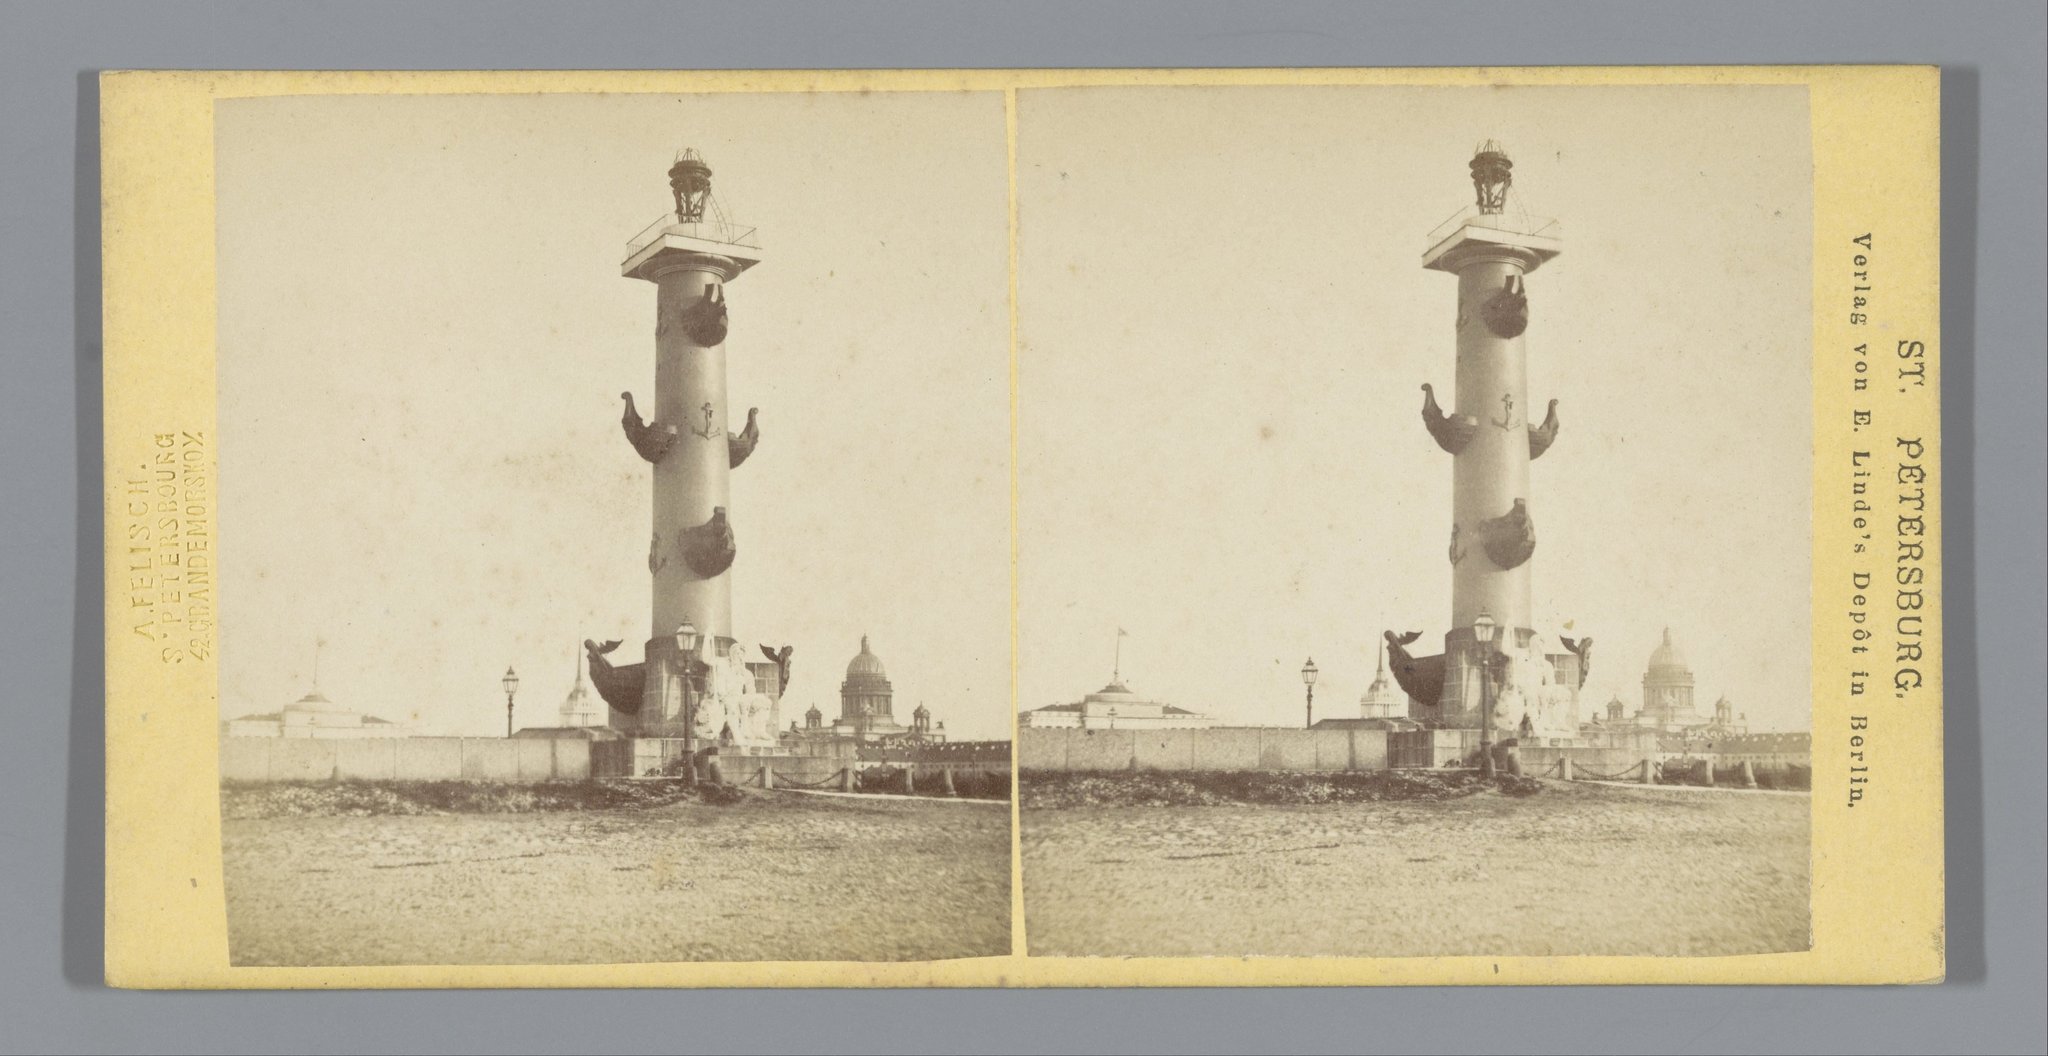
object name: stereograph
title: Vuurtoren in Sint-Petersburg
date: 1850-1880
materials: cardboard, photographic support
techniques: albumen print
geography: sint-petersburg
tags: lighthouse, lightship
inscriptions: name: ‘ST. PETERSBURG. Verlag von E. Linde's Depôt in Berlin’, inscription: ‘Phare de St Petersbourg’, name: ‘A. FELISCH. S. PETERSBOURG 42. GRANDEMORSKOY.’